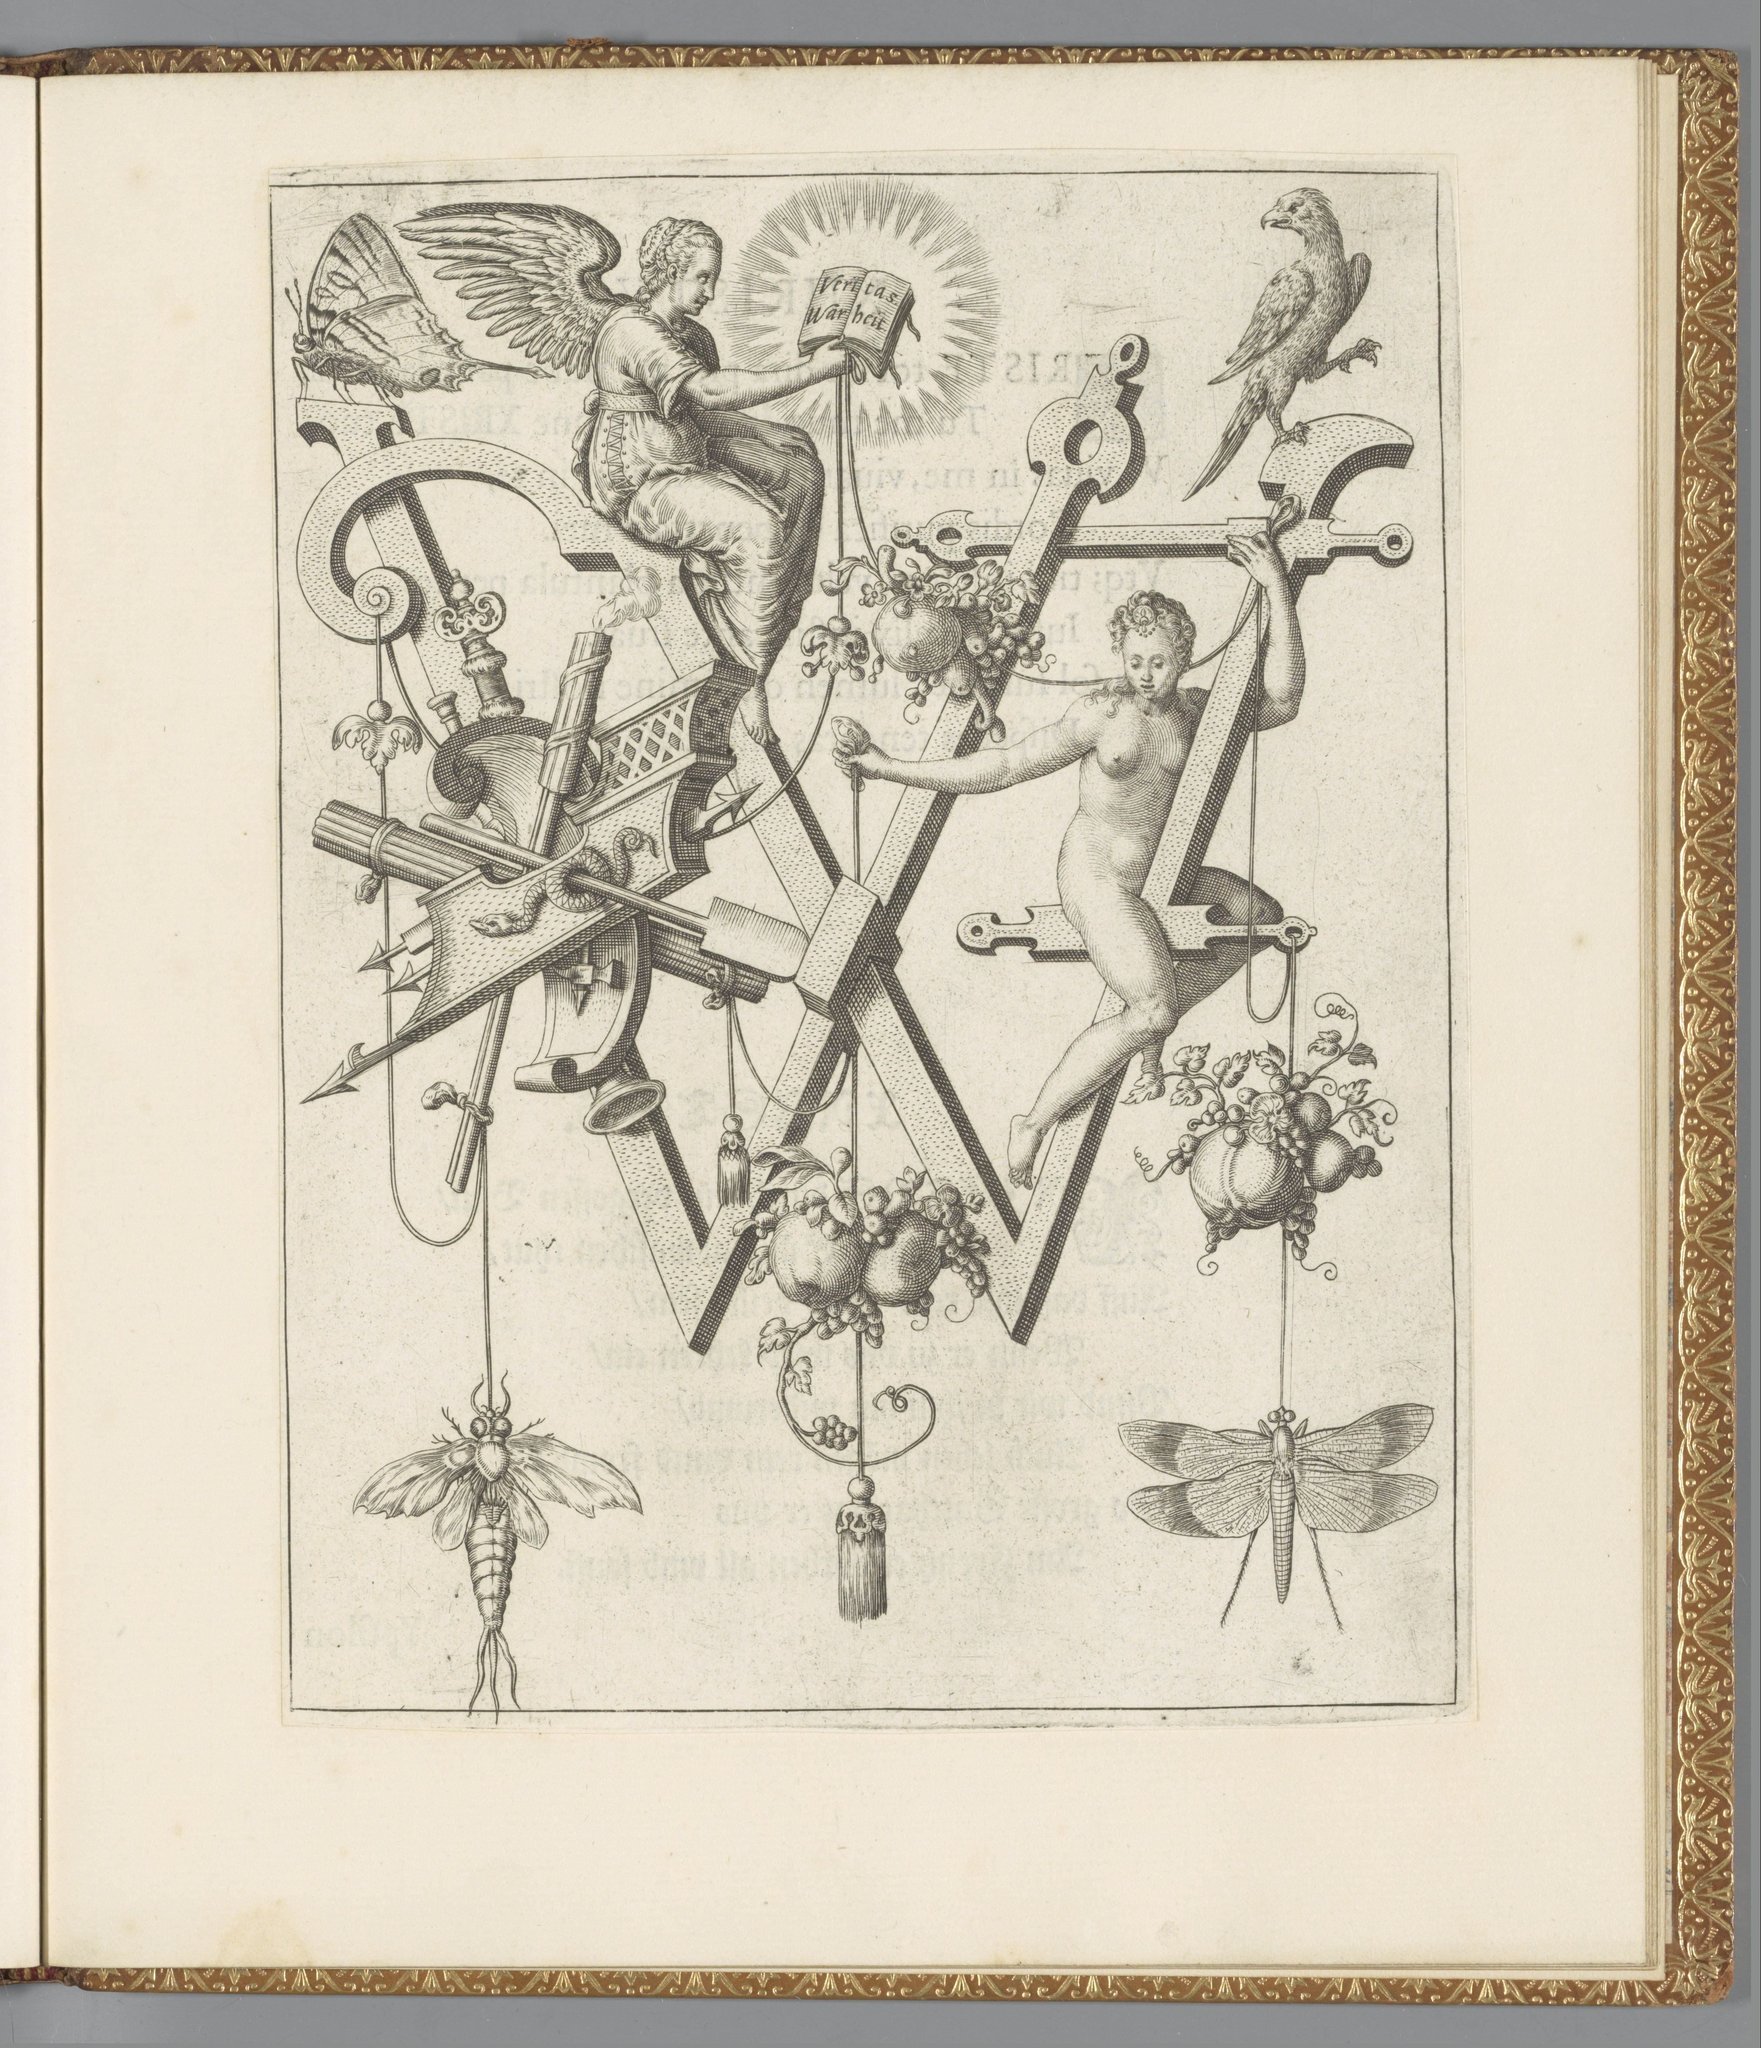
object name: album leaf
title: Ornamenteel alfabet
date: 1595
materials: paper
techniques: engraving, letterpress printing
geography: frankfurt am main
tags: fruits and vegetables ~ ornament, letters, alphabet, script, truth; 'verità' (ripa), the (nude) human figure; 'corpo humano' (ripa) - aa - female human figure, insects: butterfly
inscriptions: collector's mark: Lugt 2228, collector's mark: Lugt 2760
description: Ornamentele letter W met de gevleugelde personificatie van Waarheid met in haar handen het boek van de waarheid voor de stralende zon. Rechts een naakte vrouw. De letter is verder versierd met een trofee, een vlinder, trossen vruchten en insecten. Op verso verzen in het Latijn en het Duits. Prent maakt deel uit van een album.